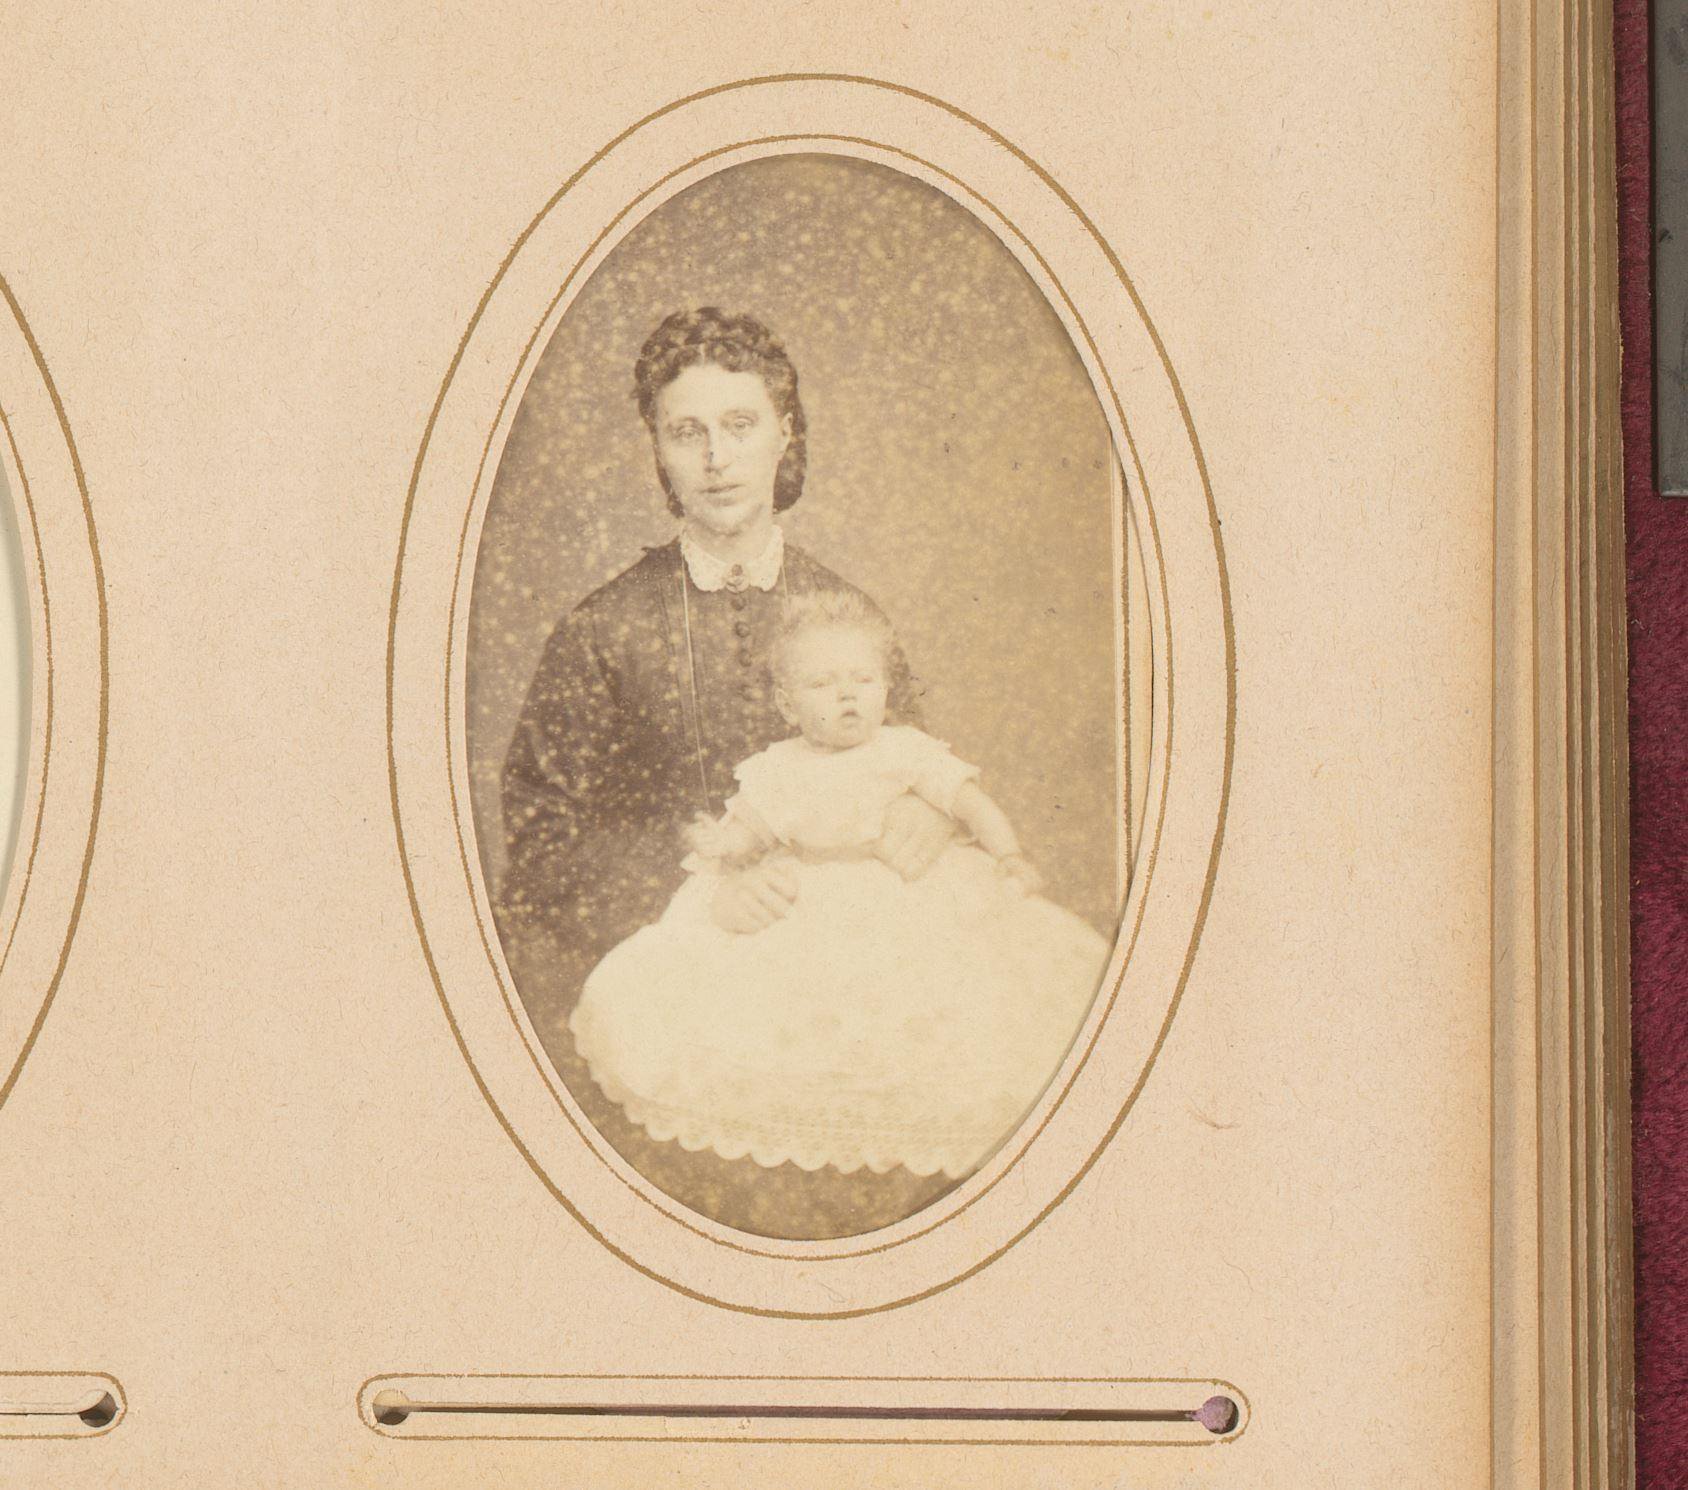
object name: photograph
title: Portret van een vrouw met baby op schoot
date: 1867-1884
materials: cardboard, photographic support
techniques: albumen print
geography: netherlands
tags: mother and baby or young child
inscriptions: inscription: ‘Photogr. Atelier/ Wegner & MOttu/ Kalverstraat D.26/ Amsterdam/ Leijdschestraatweg buiten Cathrijnen/ Utrecht’